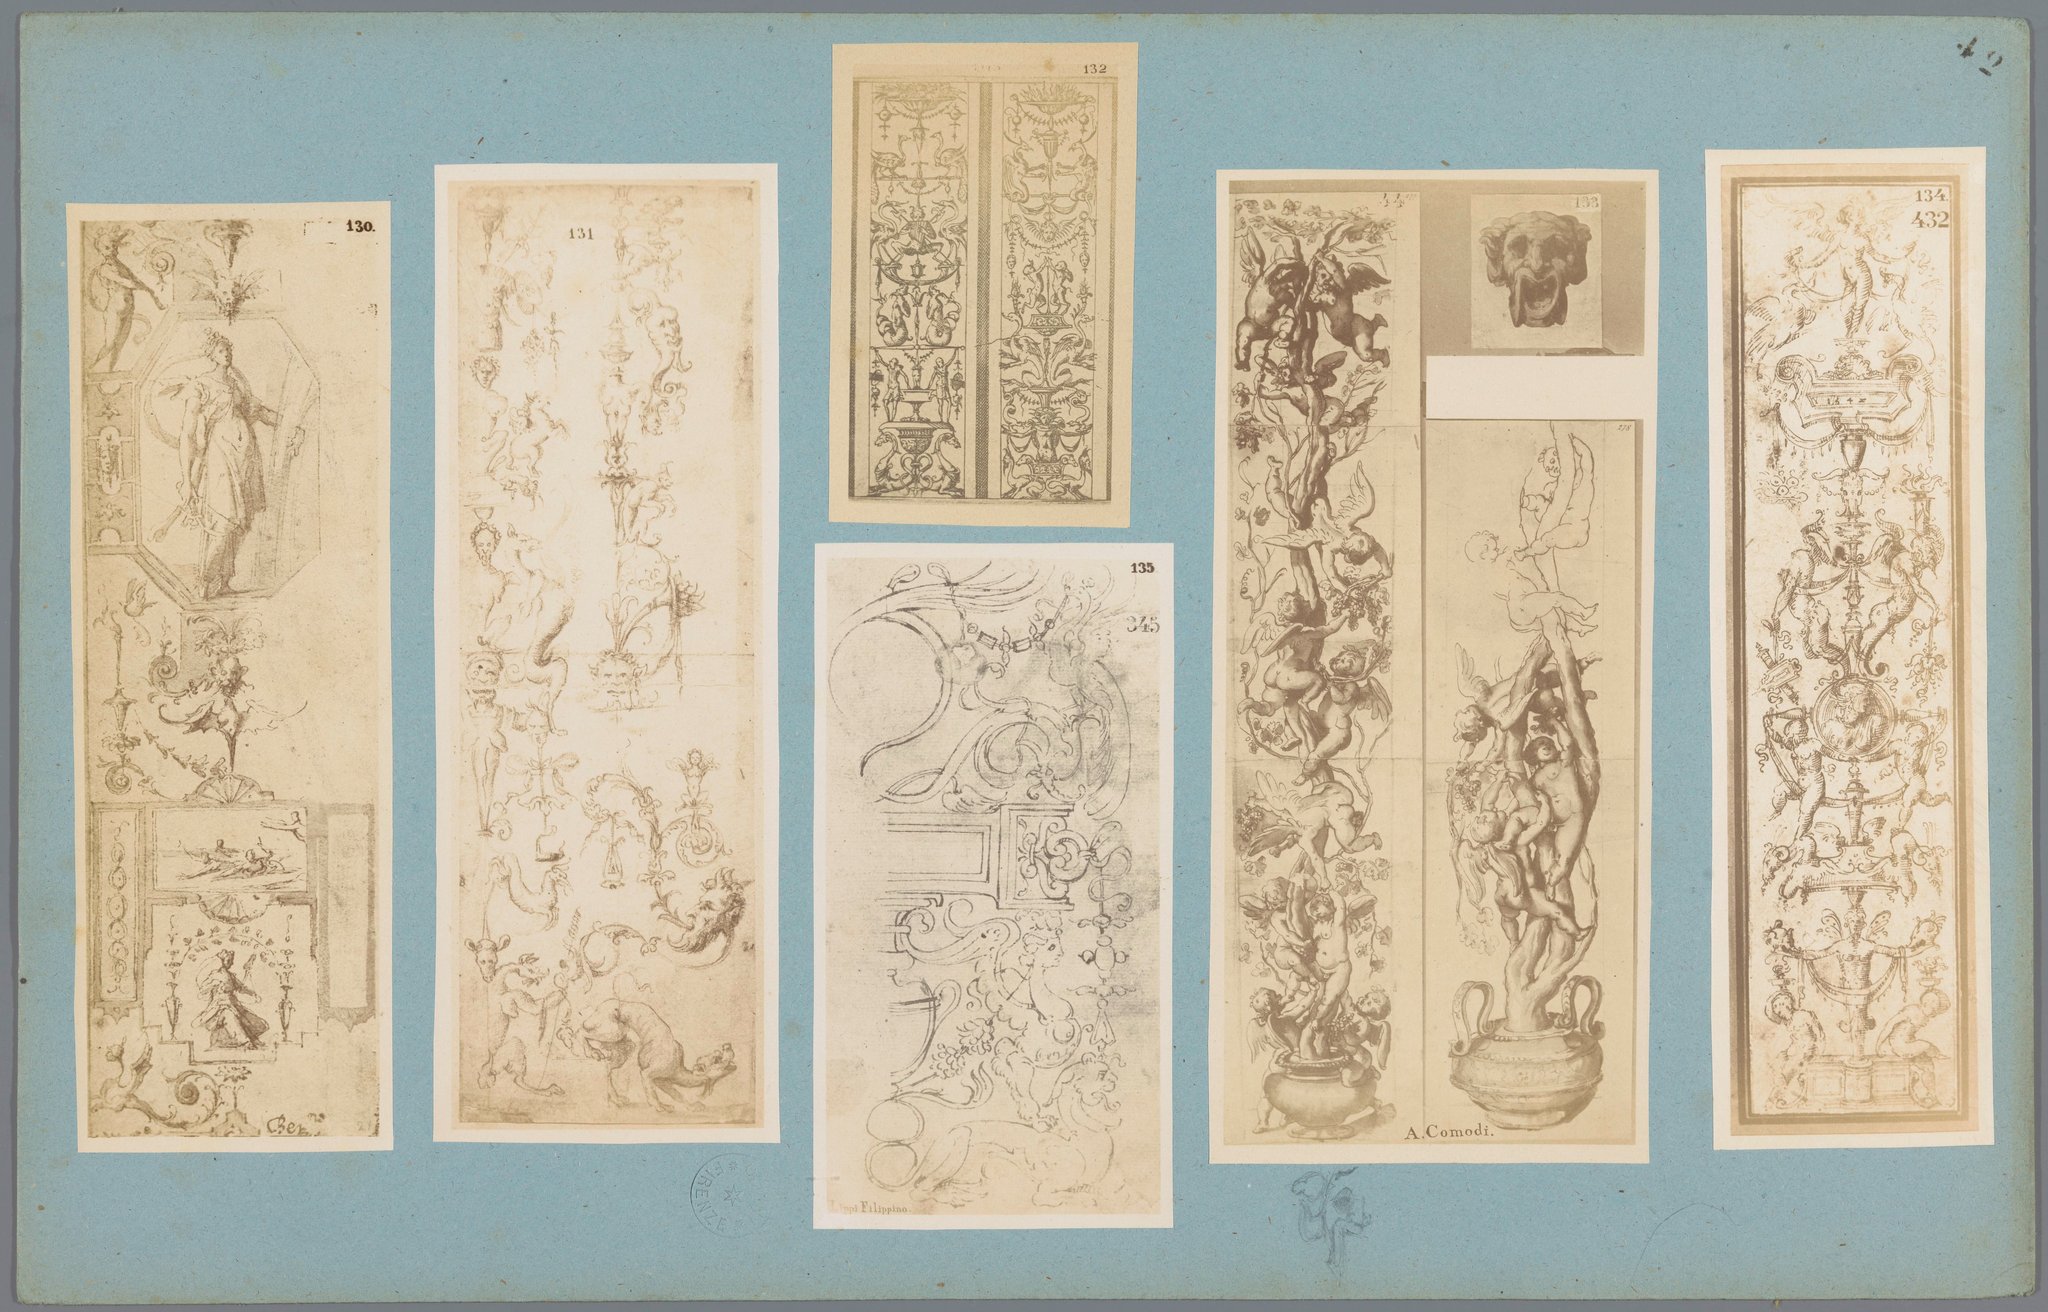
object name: photograph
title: Zes fotoreproducties van tekeningen van ornamenten, vermoedelijk wanddecoraties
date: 1875-1900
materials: cardboard, photographic support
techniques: albumen print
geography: europe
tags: vine, ornament ~ hybrid animals, print, e.g.: engraving, etching, lithograph, cupids: 'amores', 'amoretti', 'putti', europe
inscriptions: number: ‘432’, collector's mark: Lugt 3937, number: ‘133’, number: ‘132’, number: ‘42’, number: ‘130.’, number: ‘345’, name: ‘C. Pini Firenze’, number: ‘134.’, number: ‘135’, number: ‘131’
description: Van links naar rechts: (130) decoratie met een vrouwenfiguur centraal, (131) blad met fantasiedieren, (132) twee rijen met decoraties met fantasiedieren, (135) schets van decoratie met fantasiewezens door Filippino Lippi, (133) decoratie met putti in een wijnrank door Andrea Commodi, (134) decoratie met mensen en dieren.